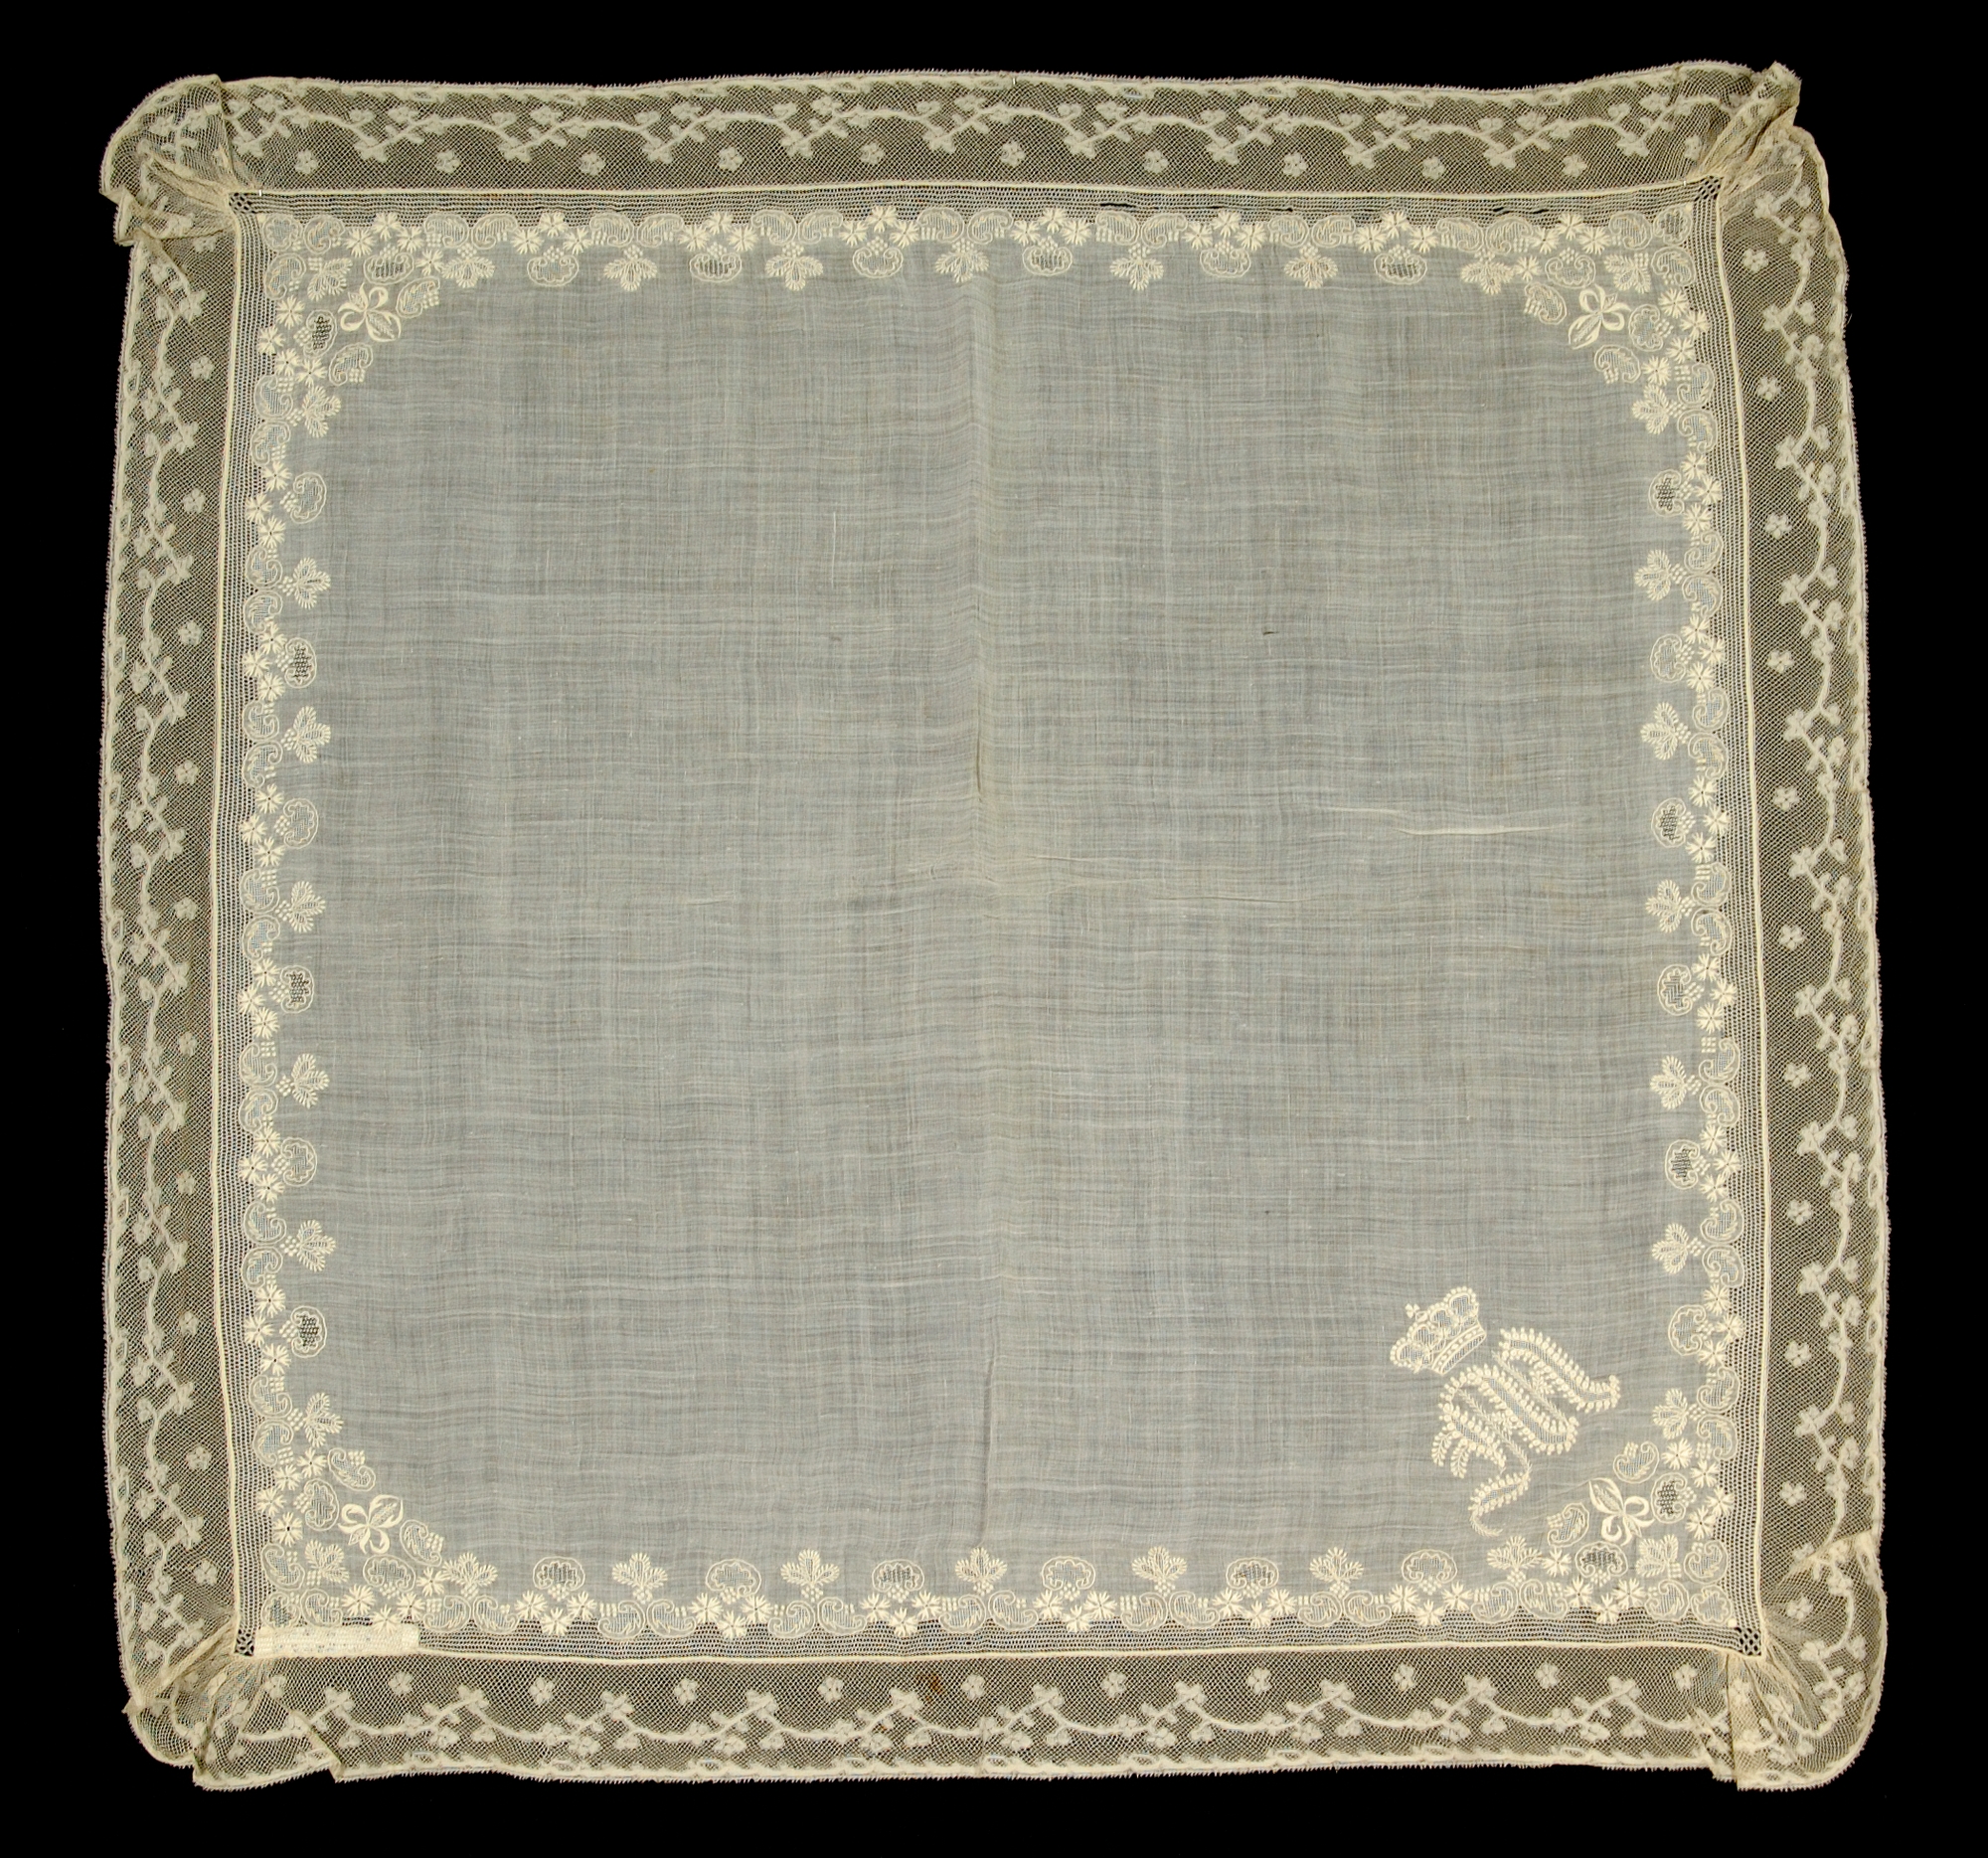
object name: court presentation handkerchief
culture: belgian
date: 1840-1860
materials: linen